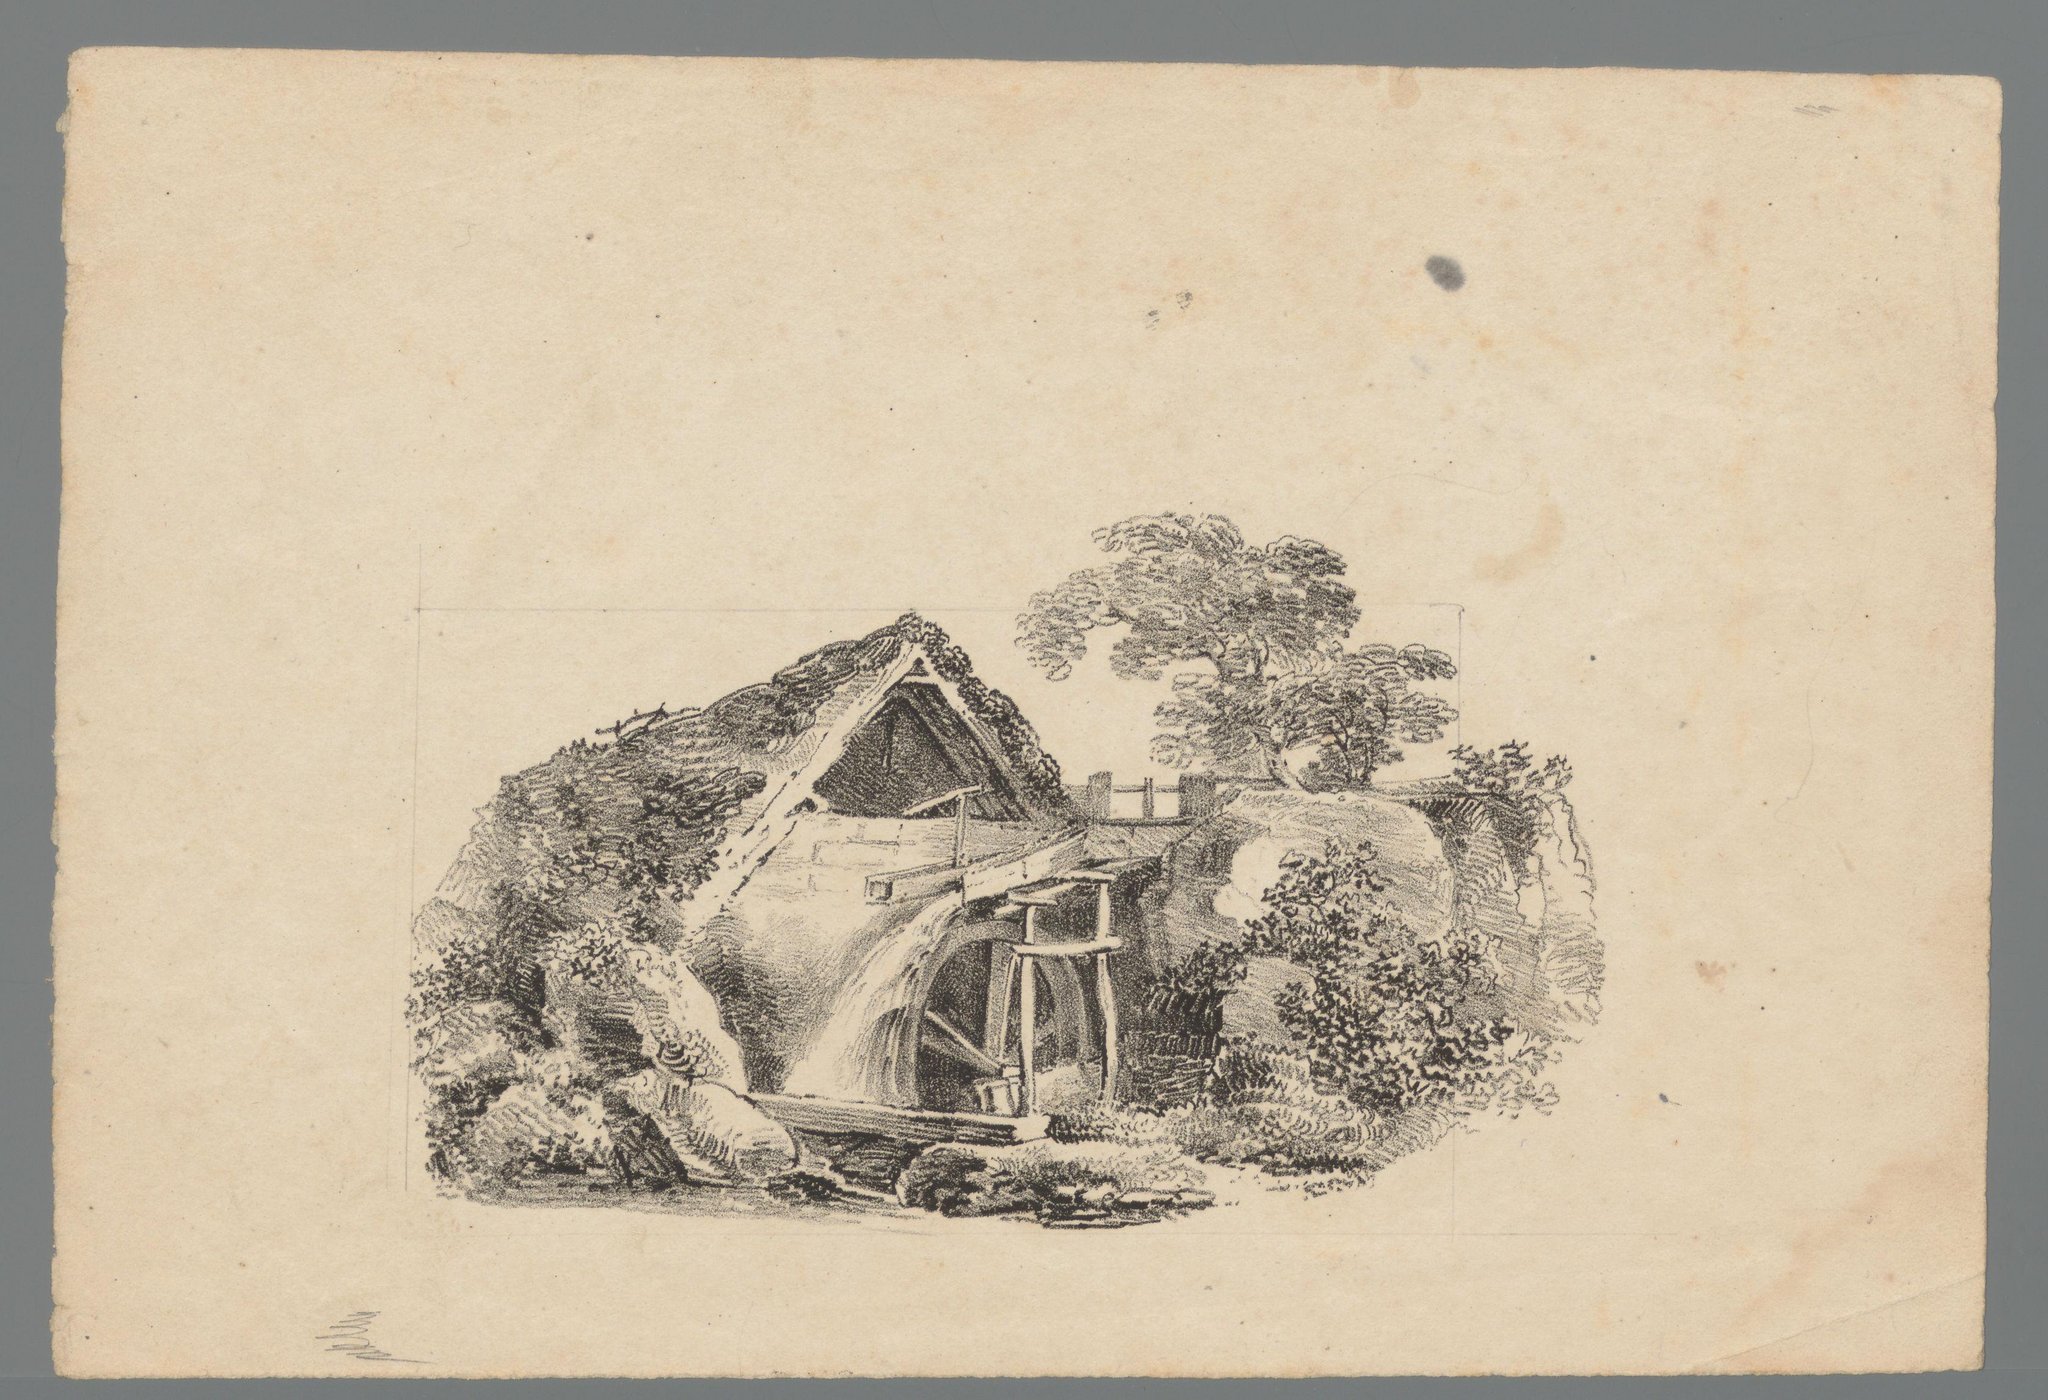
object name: print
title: Landschap met watermolen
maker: richard sasse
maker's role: print maker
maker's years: 1774-1849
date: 1800-1849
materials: paper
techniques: lithograph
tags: paddle wheel, watermill in landscape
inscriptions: collector's mark: Lugt 2228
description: Prent behoort mogelijk tot de serie 'L'art de dessiner le paysage d'apres nature'. Deze serie is in tien delen met elk zes lithografieën uitgegeven.